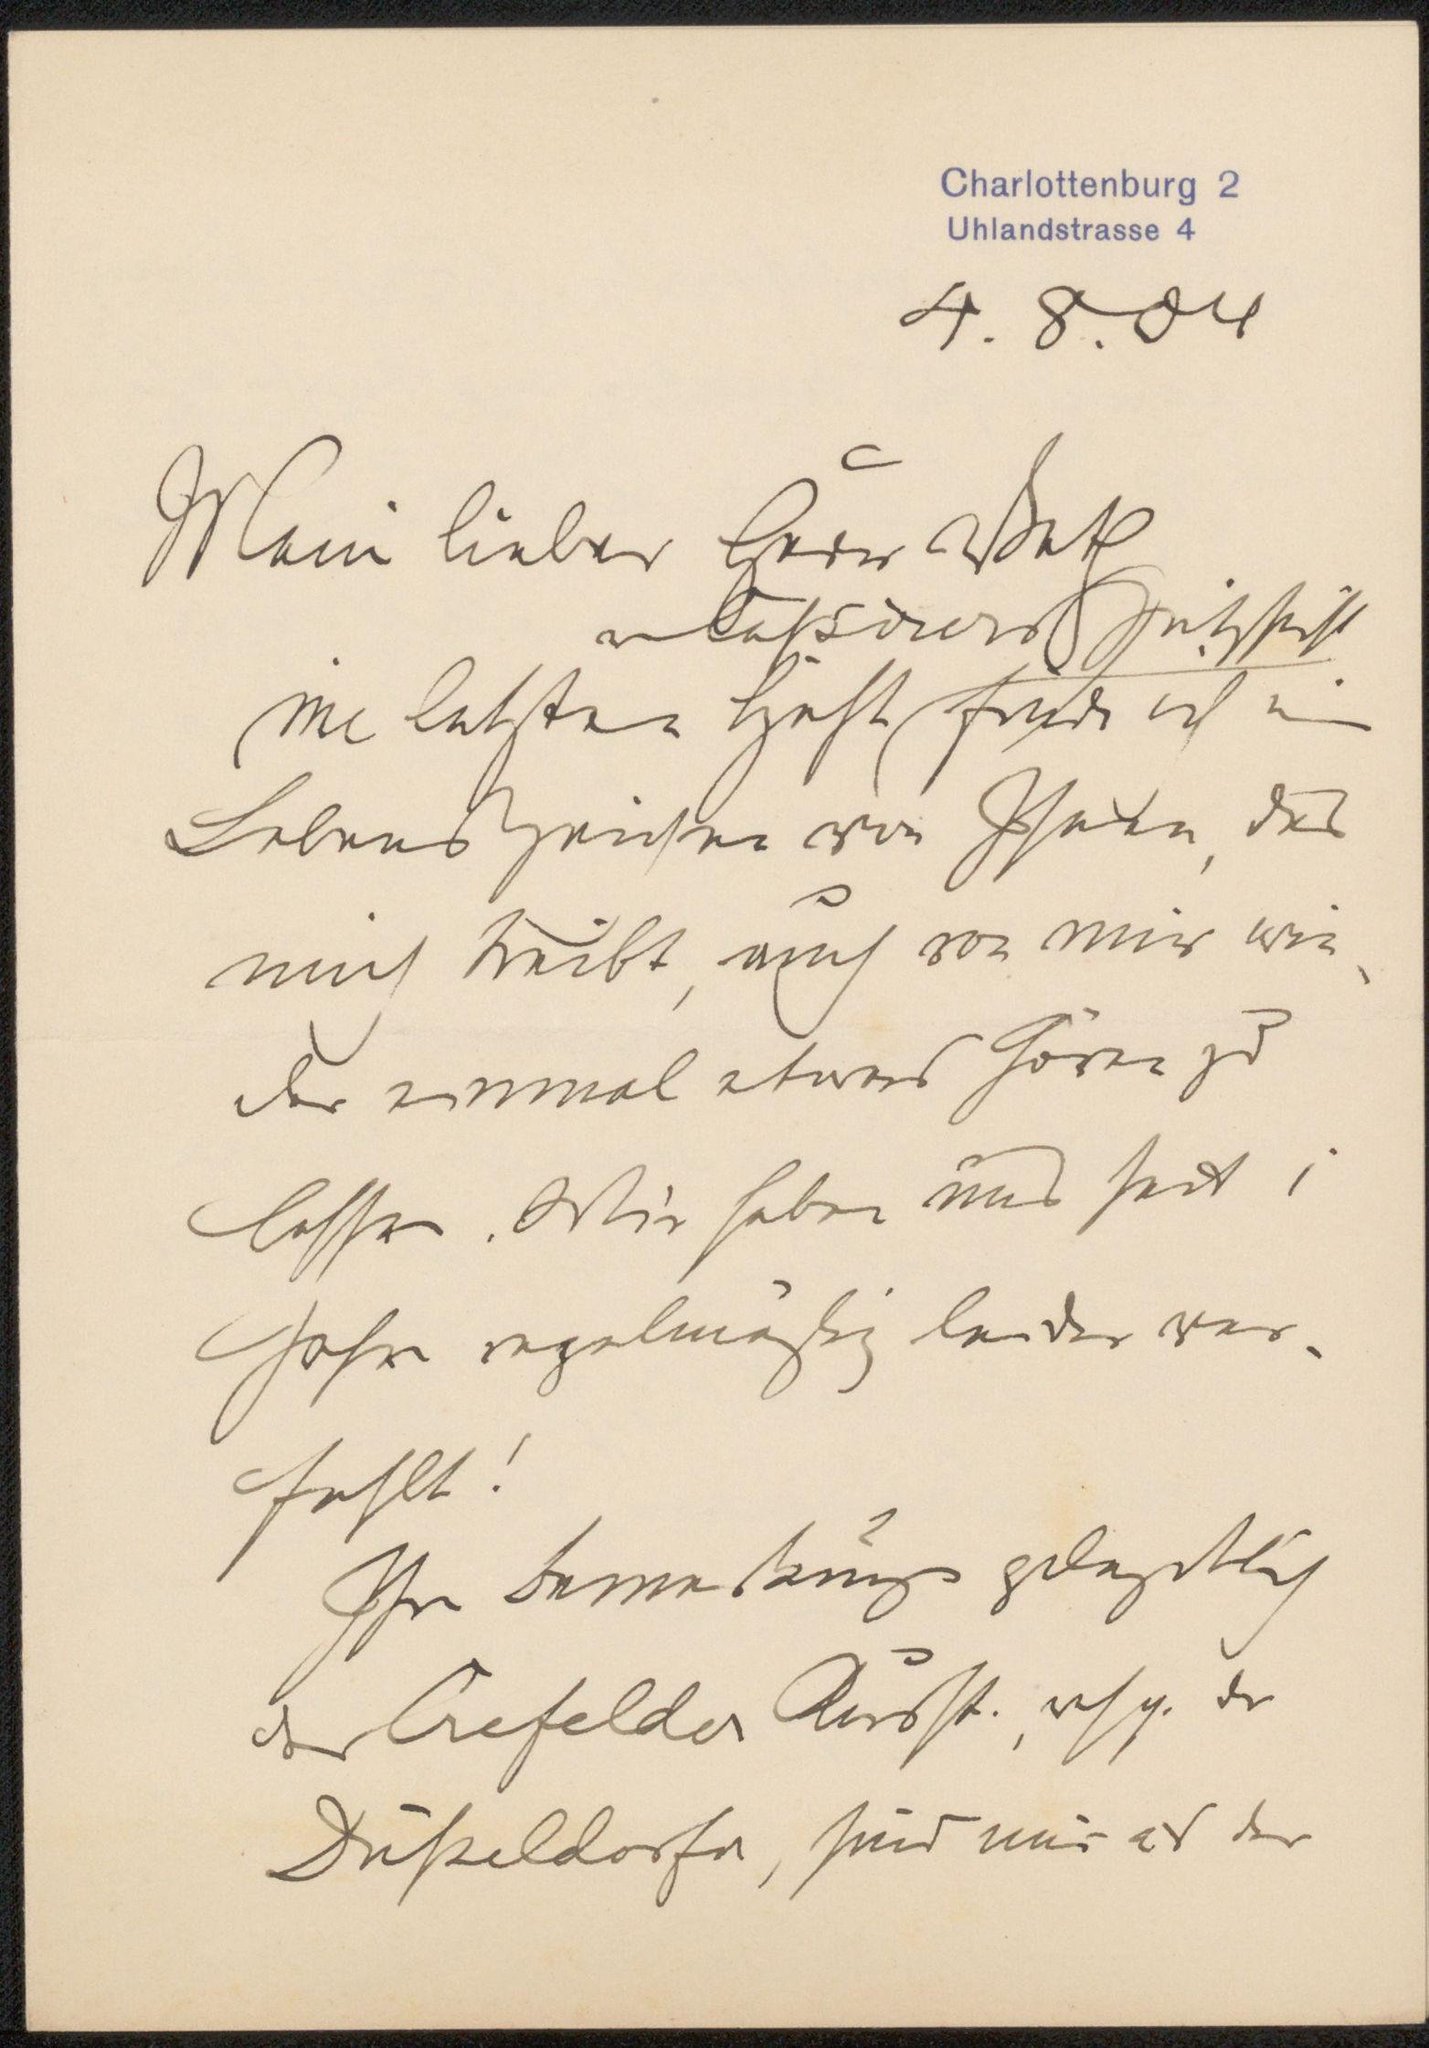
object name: letter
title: Brief aan Jan Veth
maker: wilhelm von bode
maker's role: conservator, kunsthistoricus, museumdirecteur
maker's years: 1845-1929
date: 1904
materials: ink, paper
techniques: pen, printing, writing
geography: berlin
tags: amsterdam, painter, draughtsman, designer, jan veth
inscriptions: collector's mark: ‘RPK’